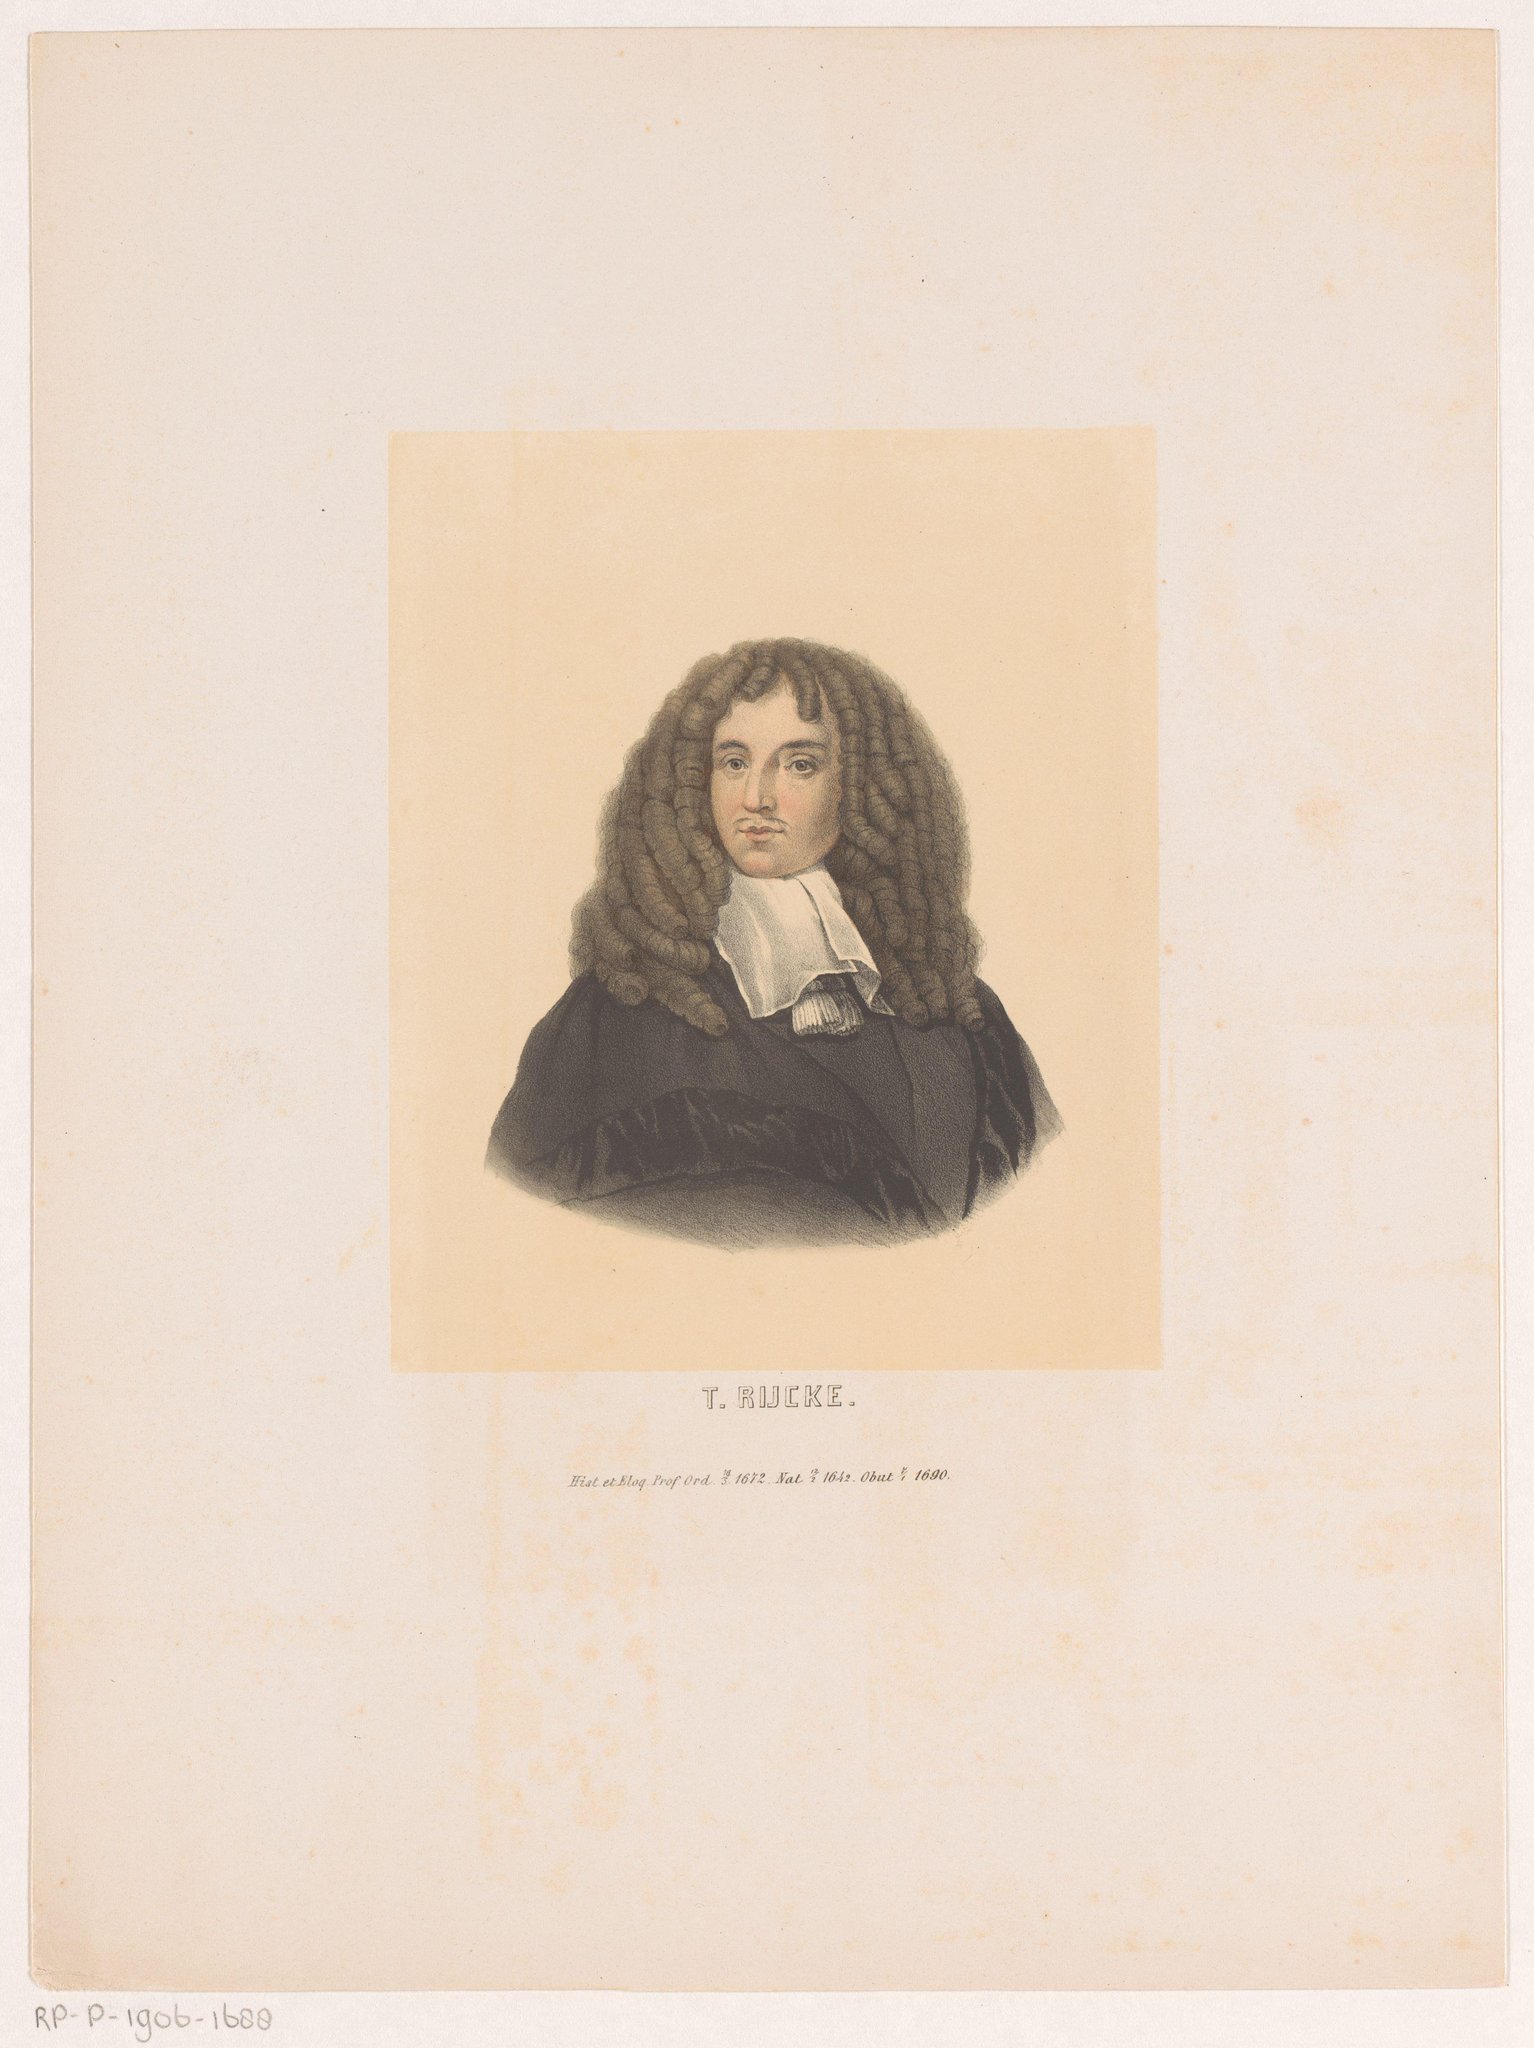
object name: print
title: Portret van Theodorus Ryckius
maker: leendert springer (i)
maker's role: draughtsman, painter, print maker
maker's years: 1789-1871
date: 1850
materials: paper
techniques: lithograph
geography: leiden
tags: arnhem, historical persons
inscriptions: collector's mark: Lugt 2228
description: Prent uit: Springer, Leendert. Galerij van hoogleeraren aan de Hoogeschool te Leijden, naar de oorspronkelijke afbeeldsels op de Senaat-zaal aldaar berustende. Leiden: Springer, Leendert., s.a. [circa 1850].